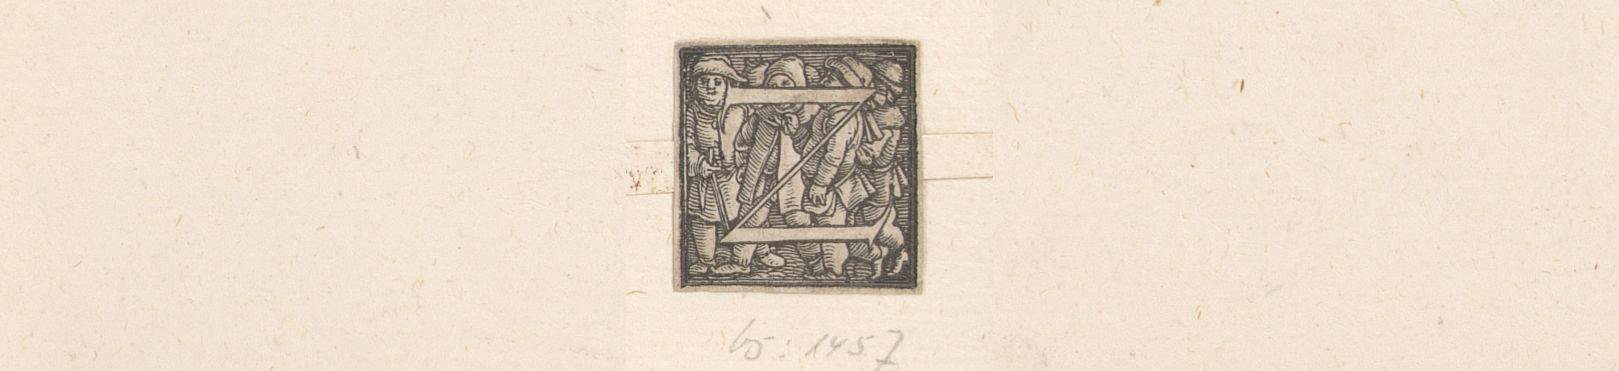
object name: book illustration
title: Latijns alfabet met boeren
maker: hans lützelburger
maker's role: print maker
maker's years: -1526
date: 1525-1526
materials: paper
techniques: woodcut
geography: basel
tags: initial, farmers